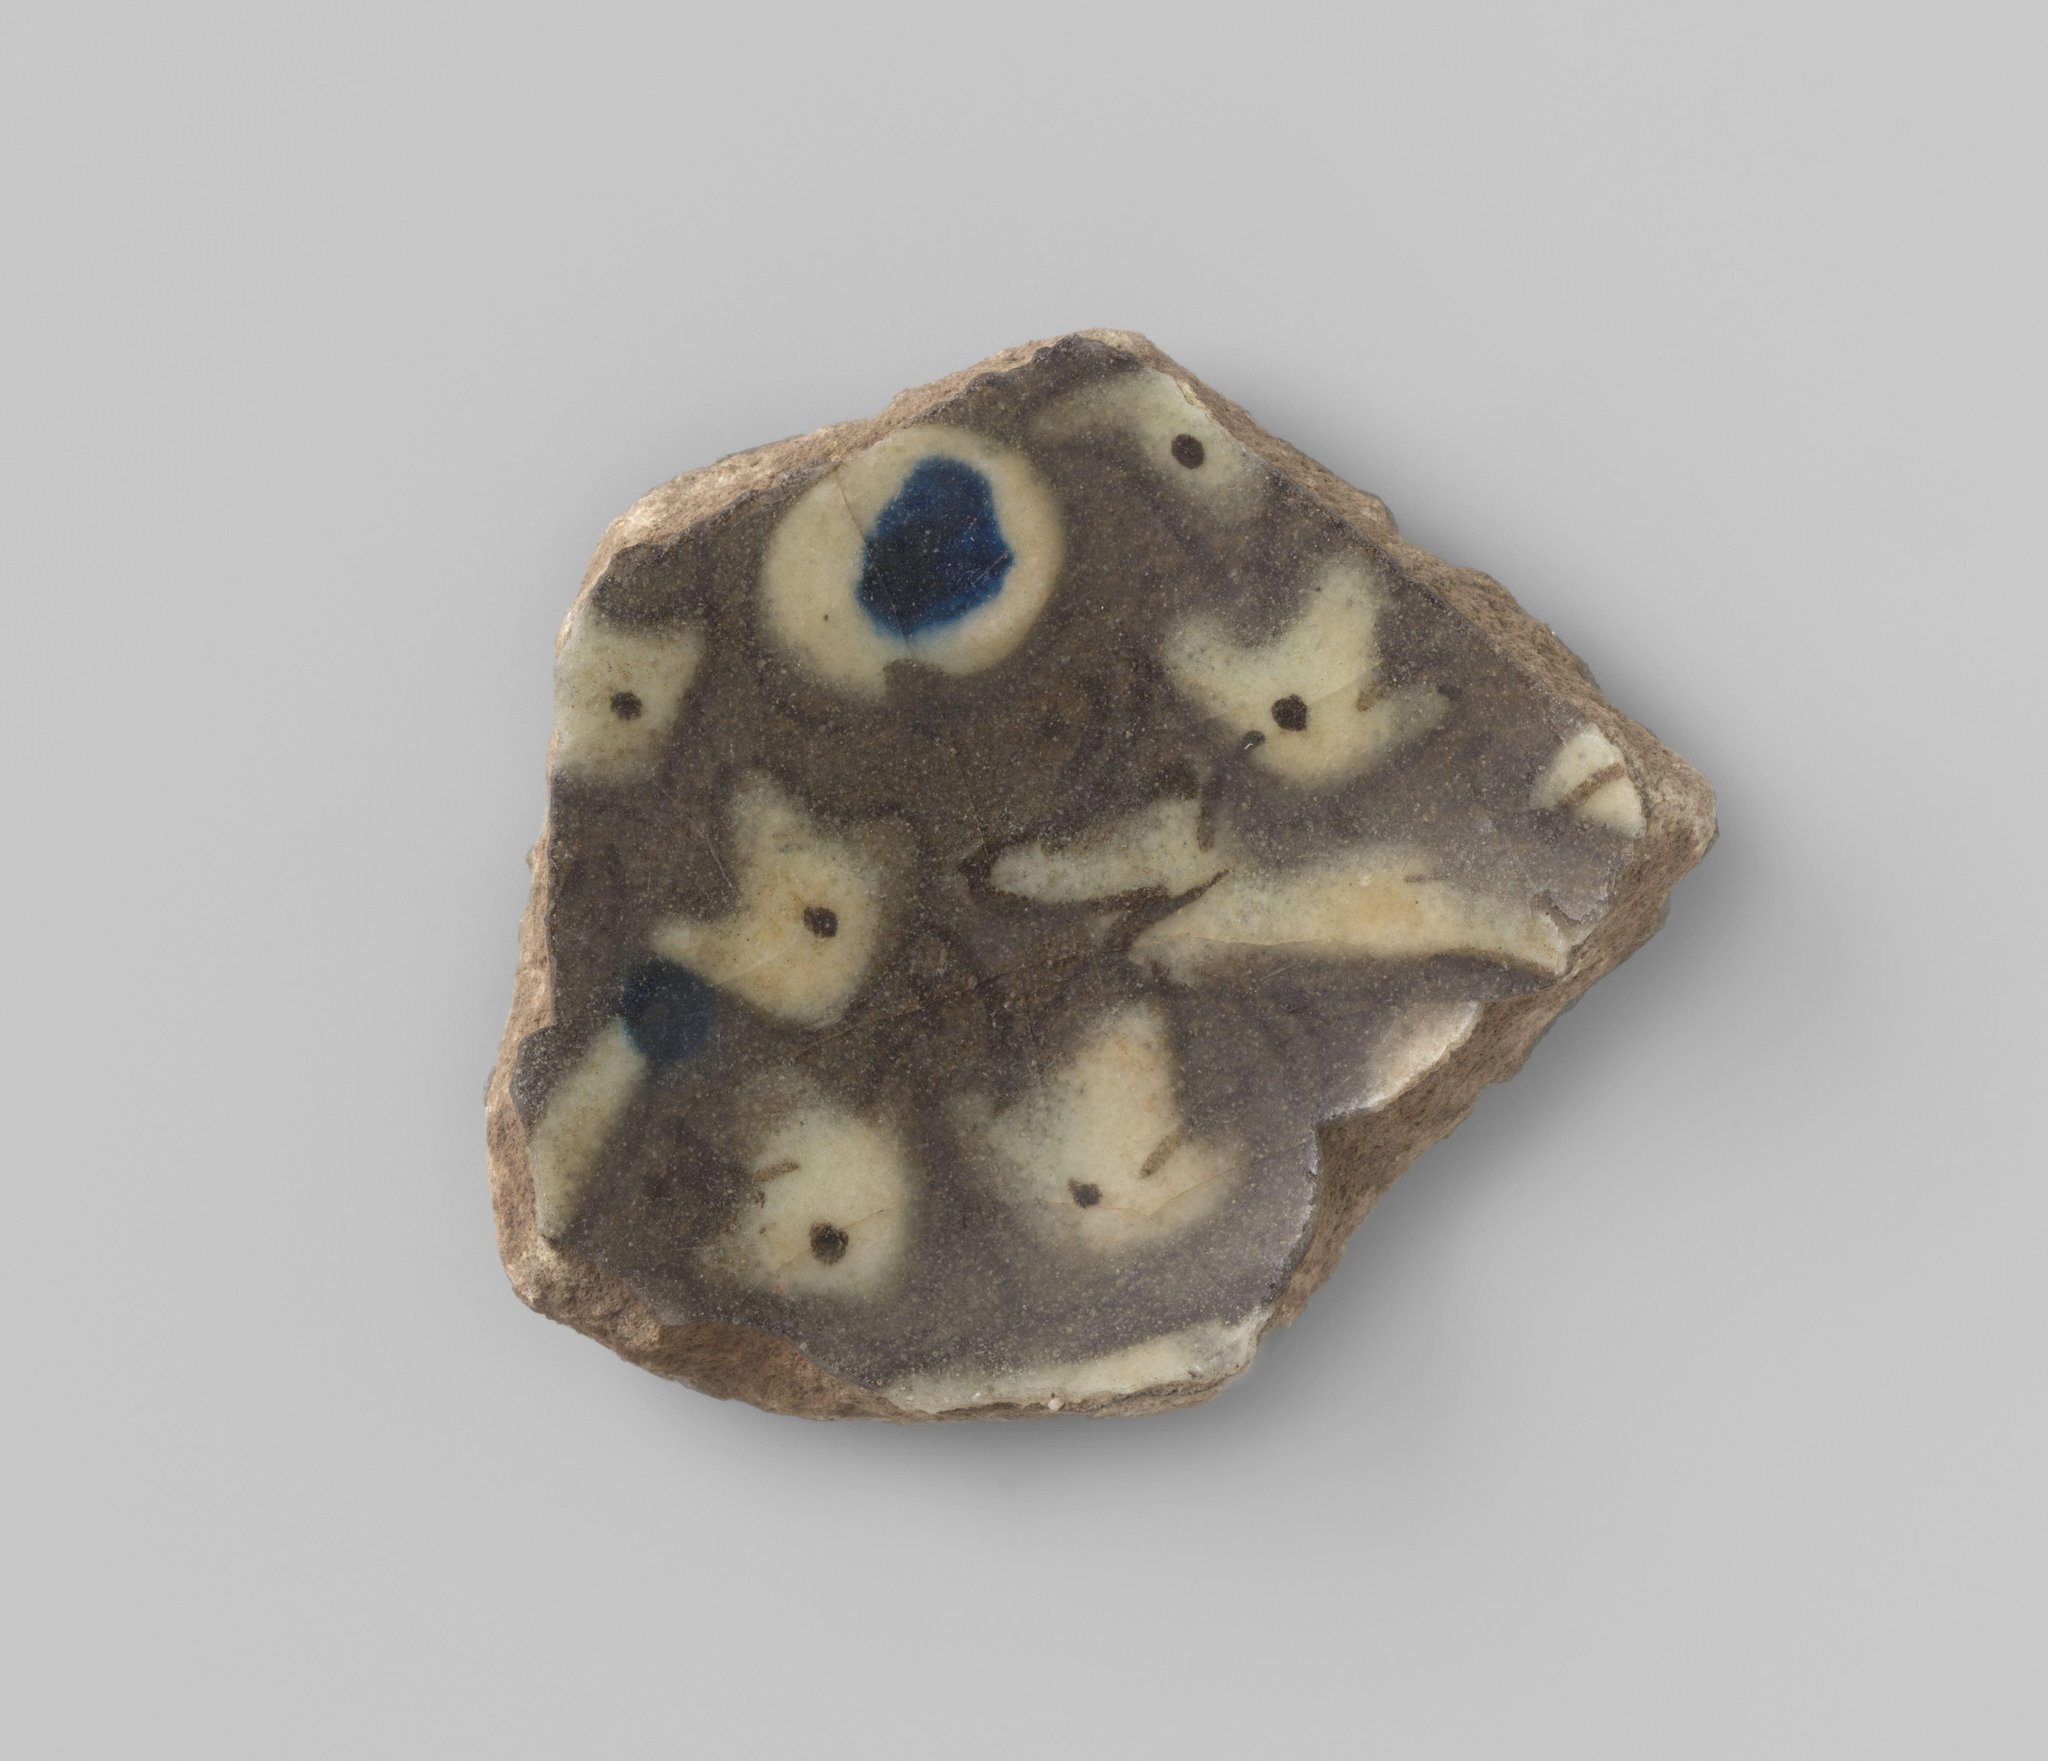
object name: sherd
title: Scherf van zachte grijswitte aarde met glazuur over zwarte doorschijnende ondertekening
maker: Anonymous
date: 1300-1400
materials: earthenware, glaze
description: Scherf van zachte grijswitte aarde met glazuur over zwarte doorschijnende ondertekening. Op een donker grijze fond verheffen zich, in reliëf, witte driepuntige blaadjes alle met een zwarte stip en een ovaal. Egypte.